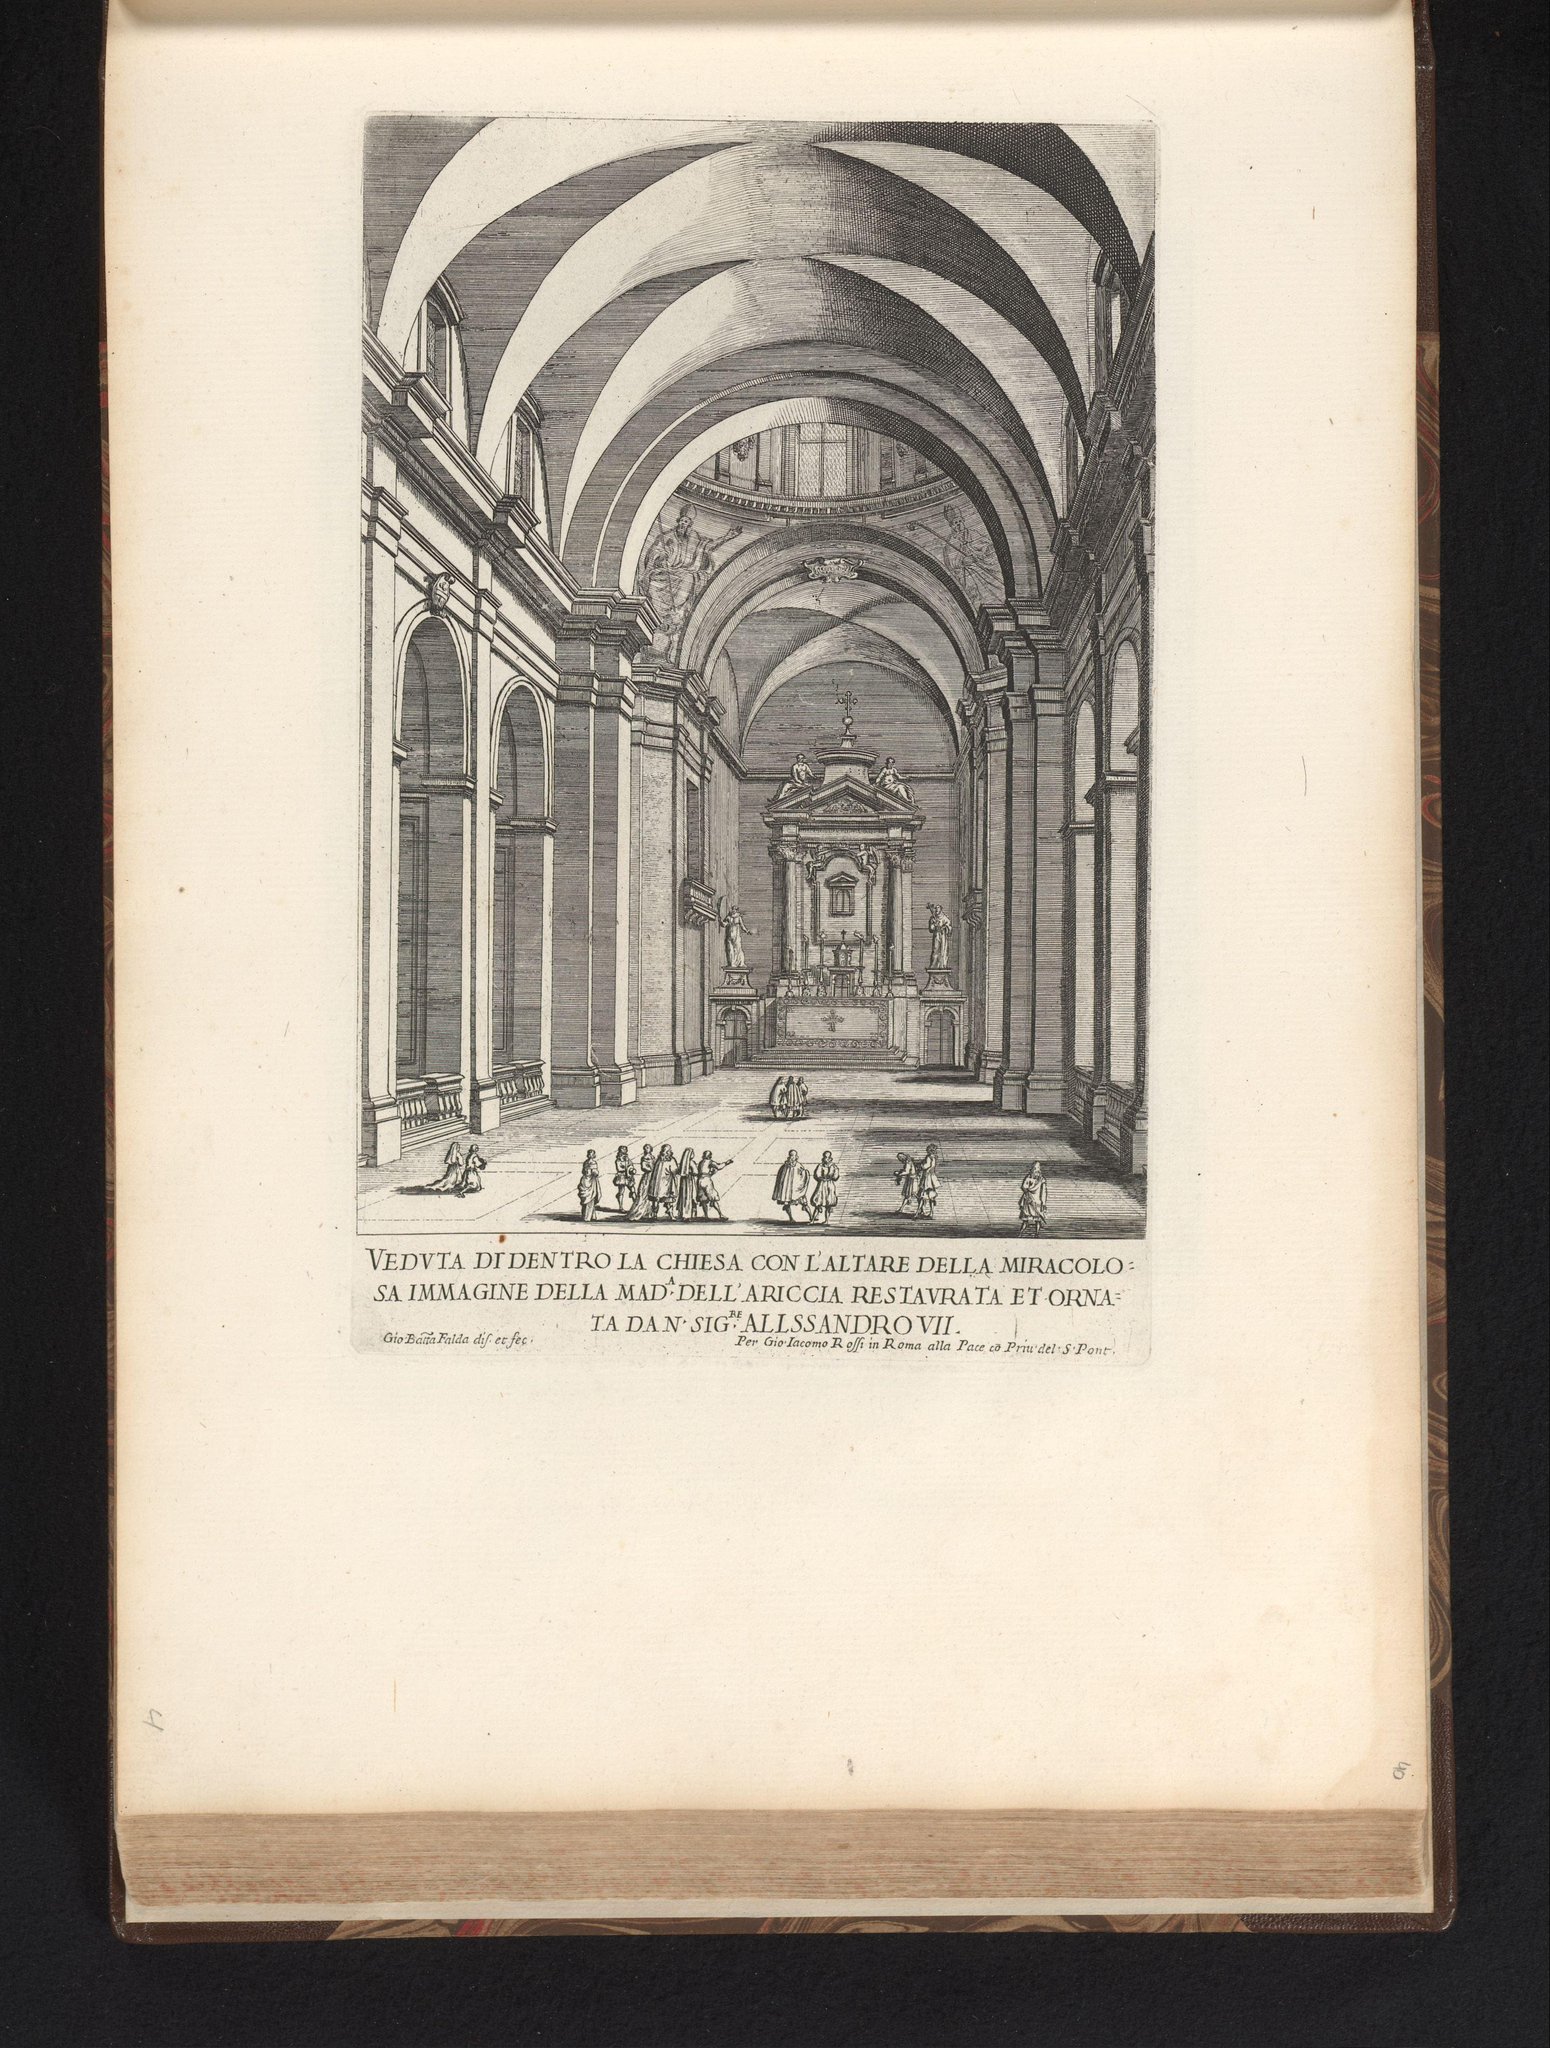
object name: album leaf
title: Interieur van de kerk de Collegiata di Santa Maria Assunta te Ariccia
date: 1665-1667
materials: paper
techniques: etching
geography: italy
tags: interior of church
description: Deze prent maakt deel uit van een reeks van 17 prenten met voorstellingen van gebouwen in Rome. Samen met vier andere reeksen vormt het de grote reeks: 'Il nuovo teatro di Roma moderna'.